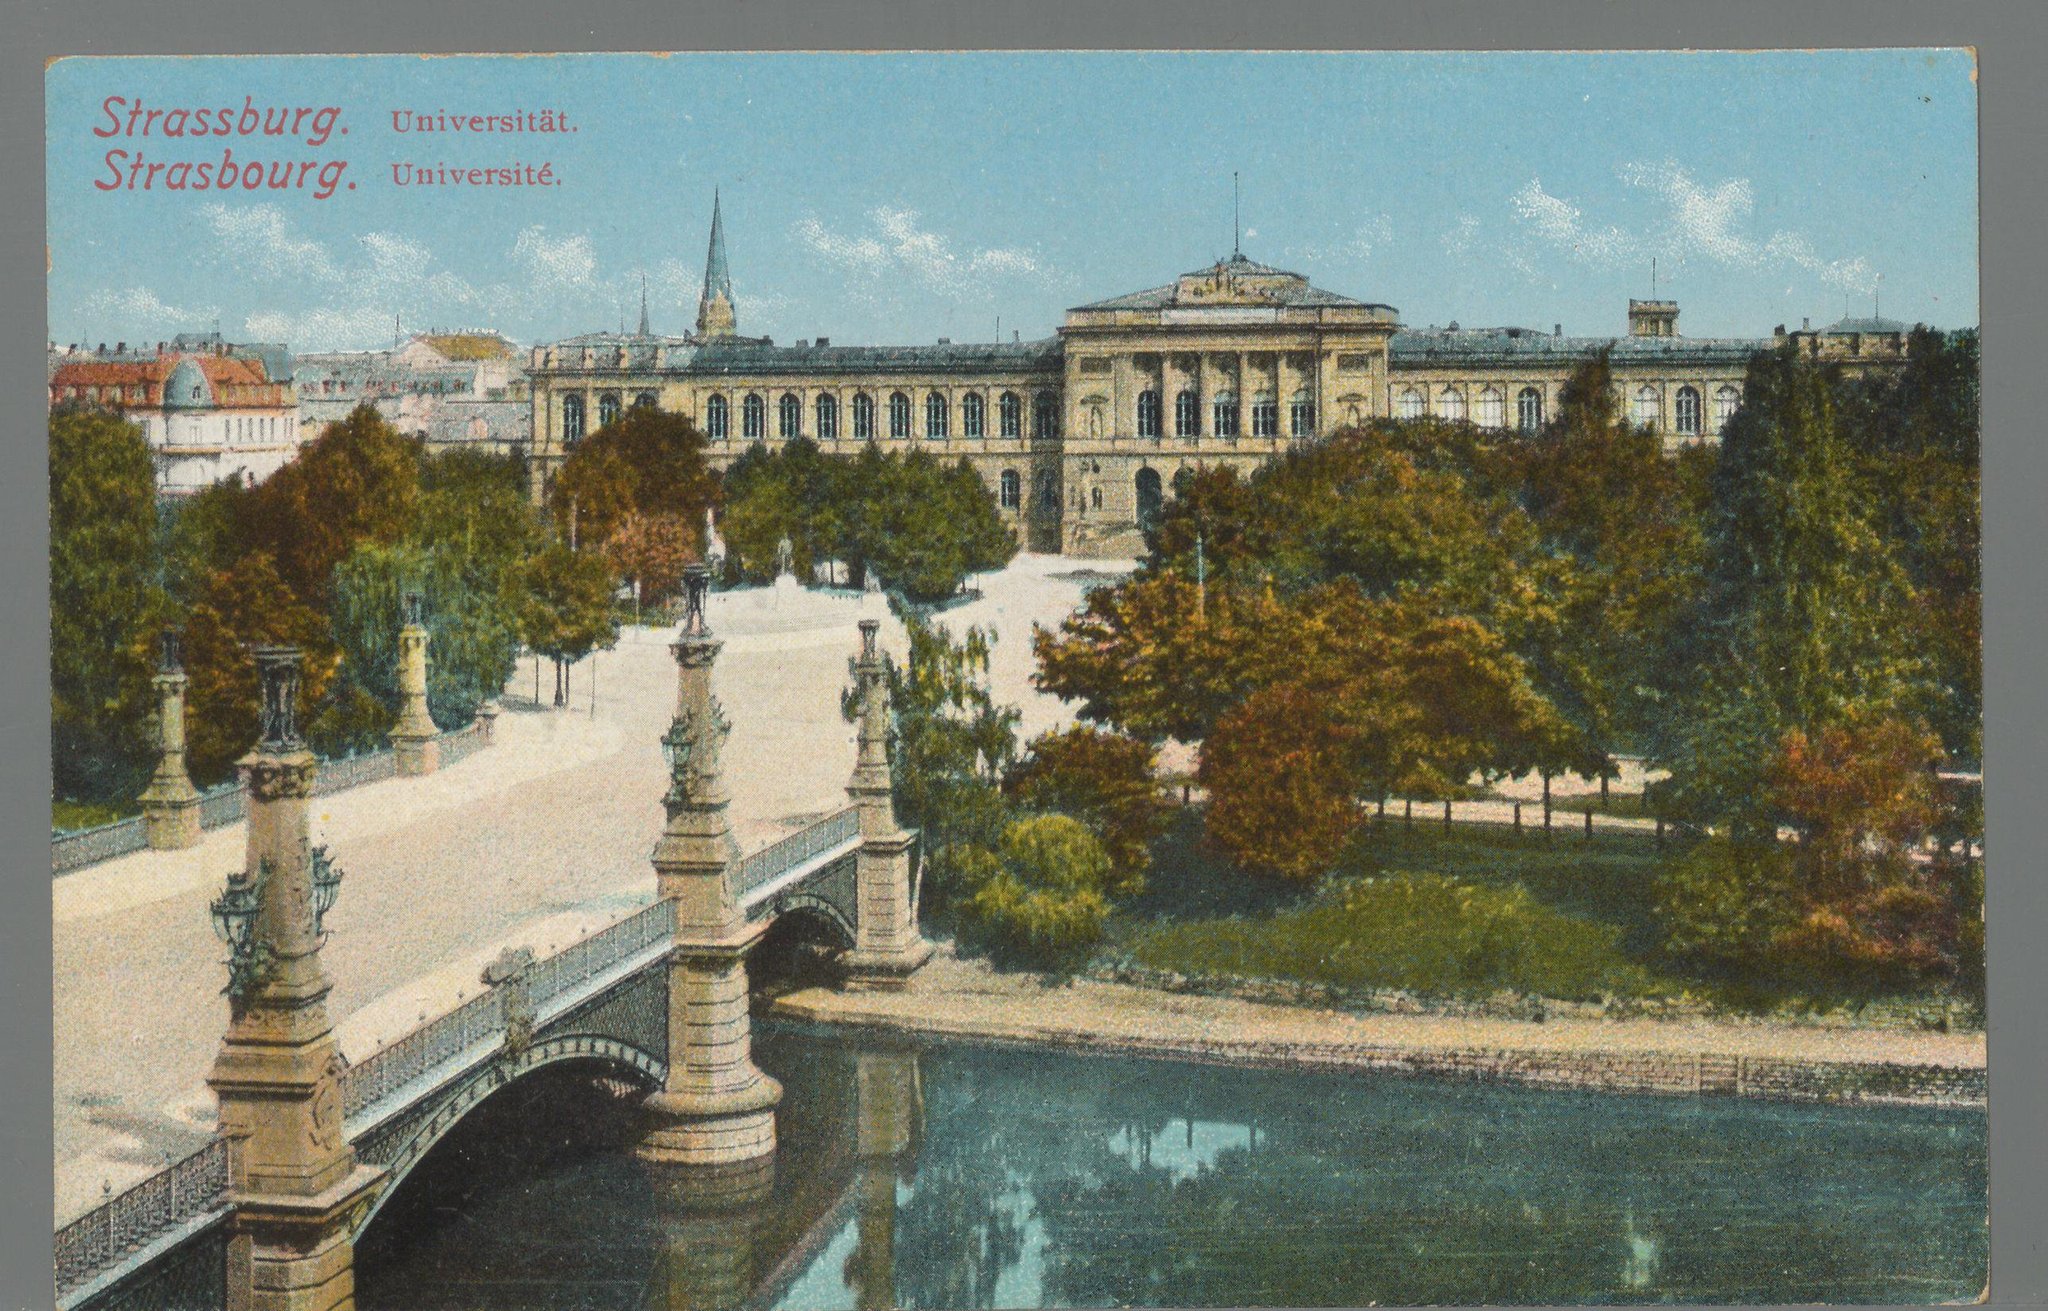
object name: photomechanical print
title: Strassburg. Universität / Strasbourg. Université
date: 1905-1930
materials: cardboard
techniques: lithograph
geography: straatsburg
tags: university building, college